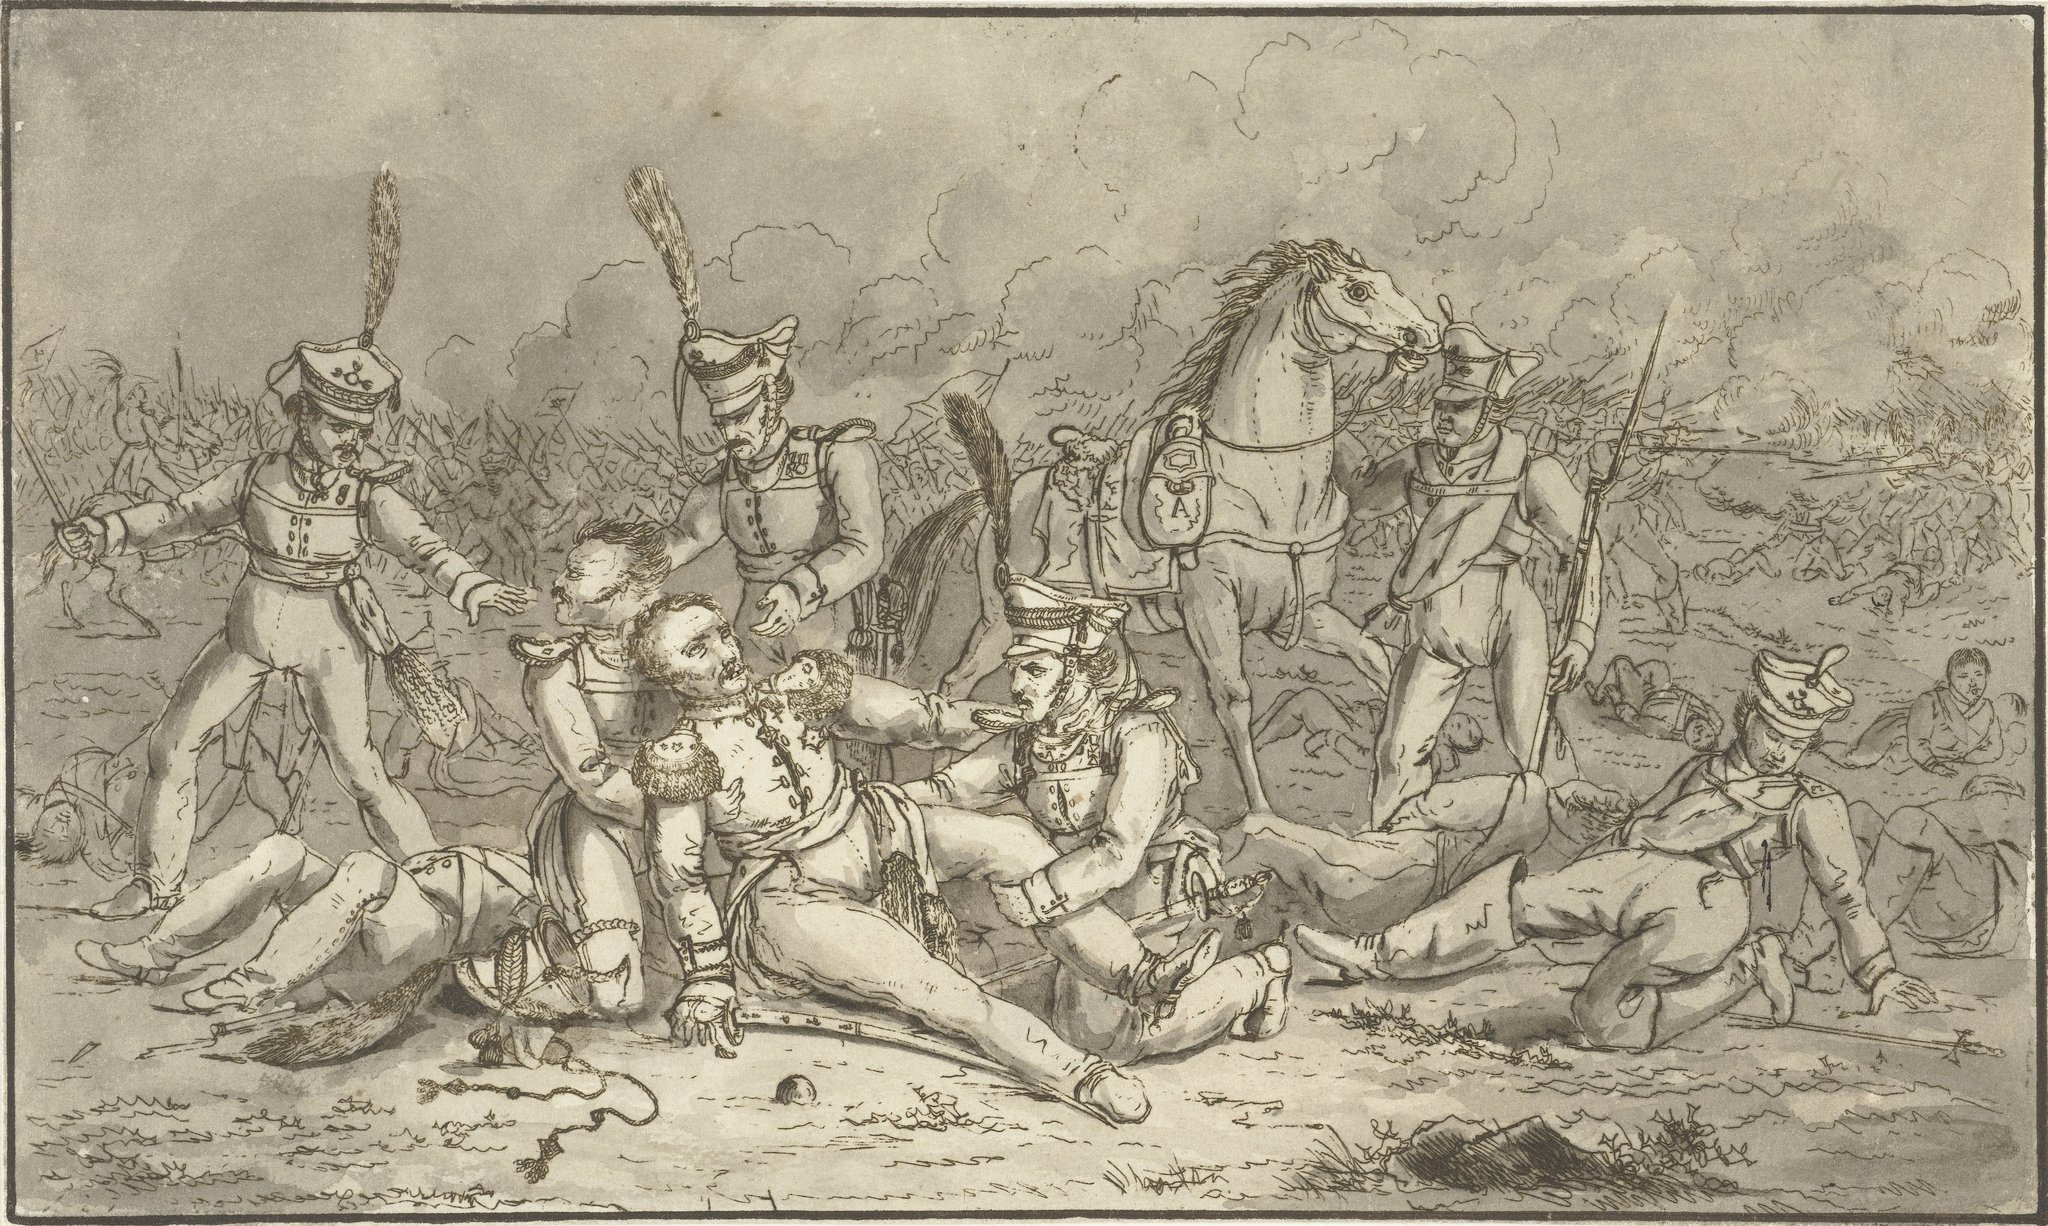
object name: print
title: Gesneuvelde generaal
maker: gerardus emaus de micault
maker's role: draughtsman, print maker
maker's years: 1798-1863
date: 1814-1863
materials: paper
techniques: brush, etching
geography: netherlands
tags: battle (+ cavalry, horsemen)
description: Een van zijn paard gevallen generaal wordt geholpen door zijn mannen. Op de achtergrond is een veldslag gaande.